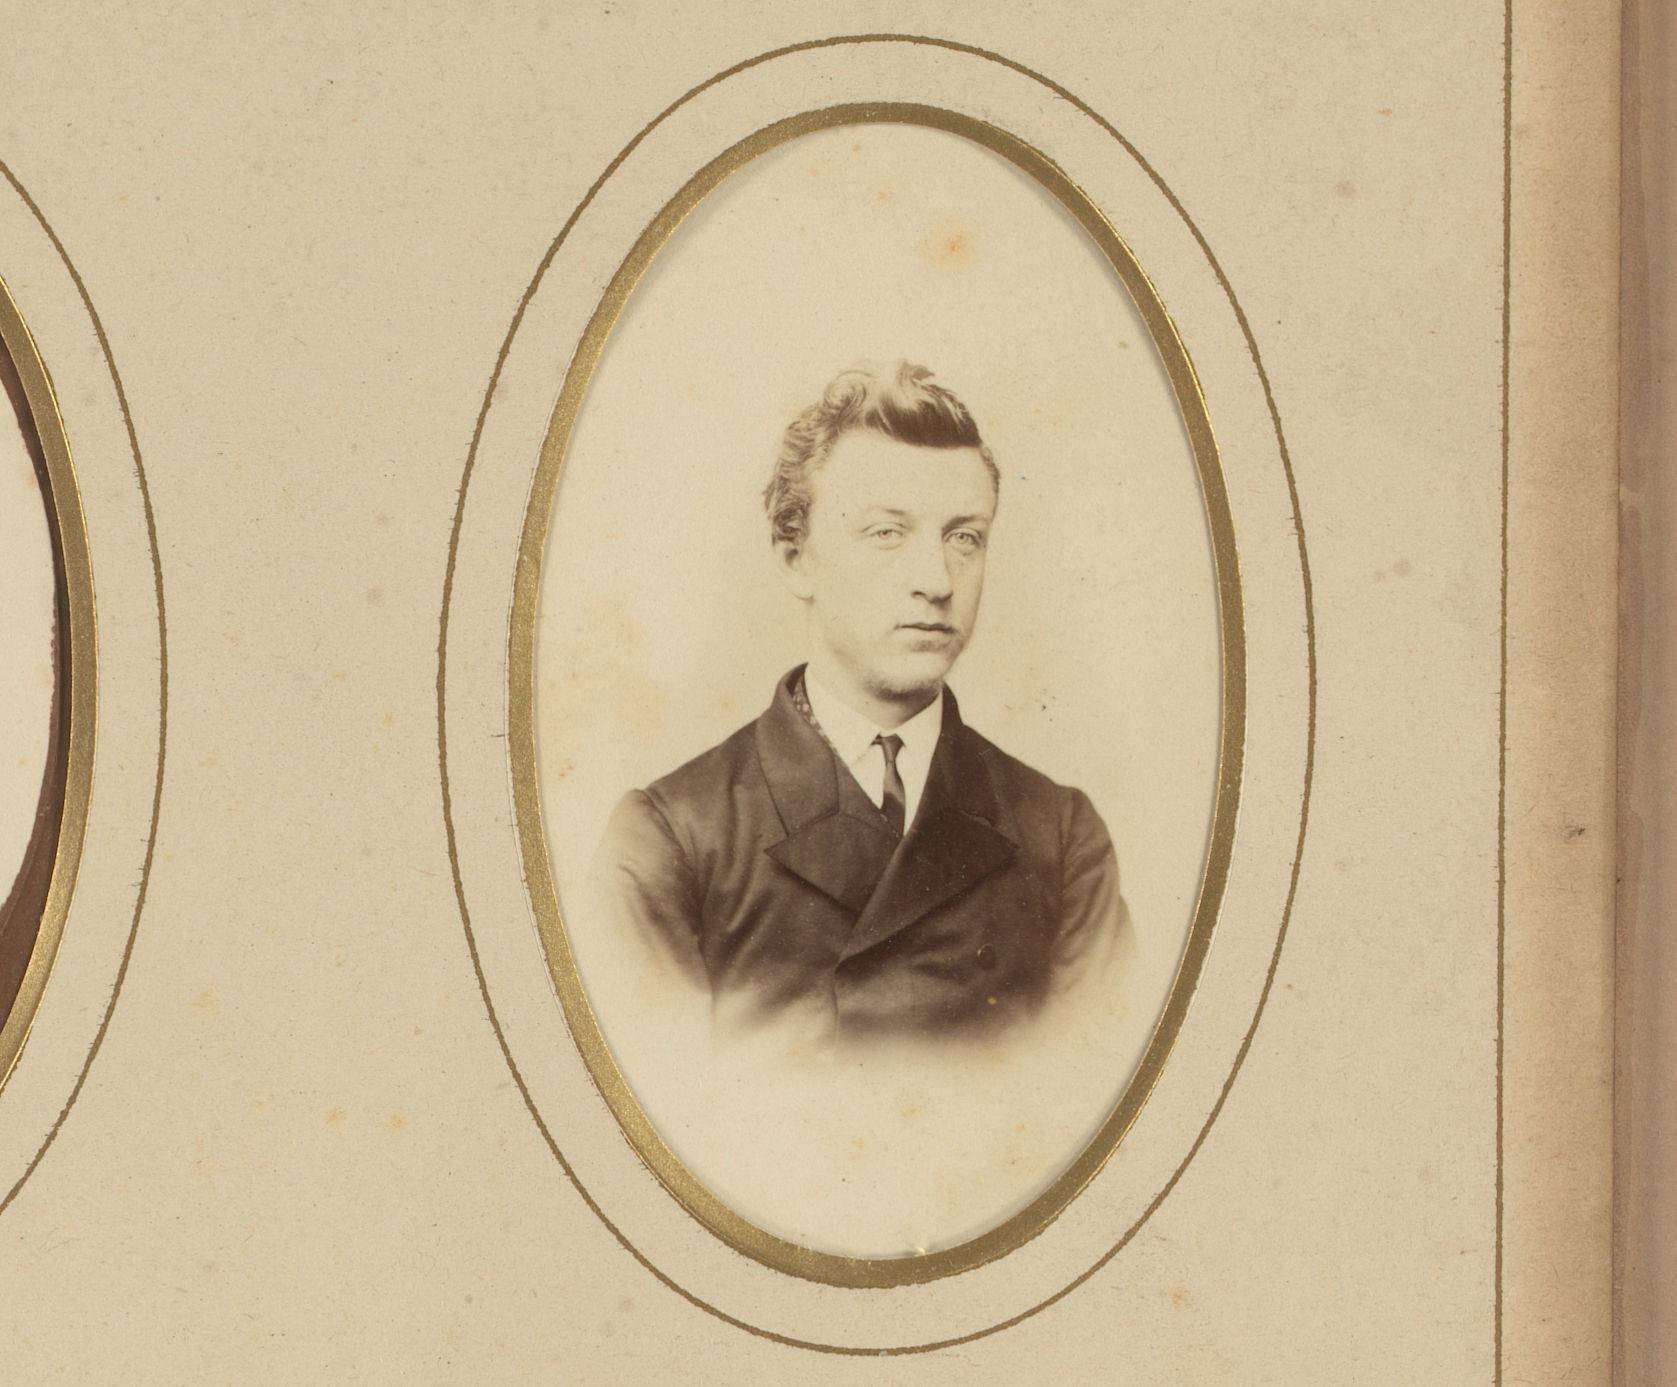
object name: album leaf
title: Portret van een jongeman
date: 1860-1900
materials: cardboard, photographic support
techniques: albumen print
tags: historical persons, youth, adolescent